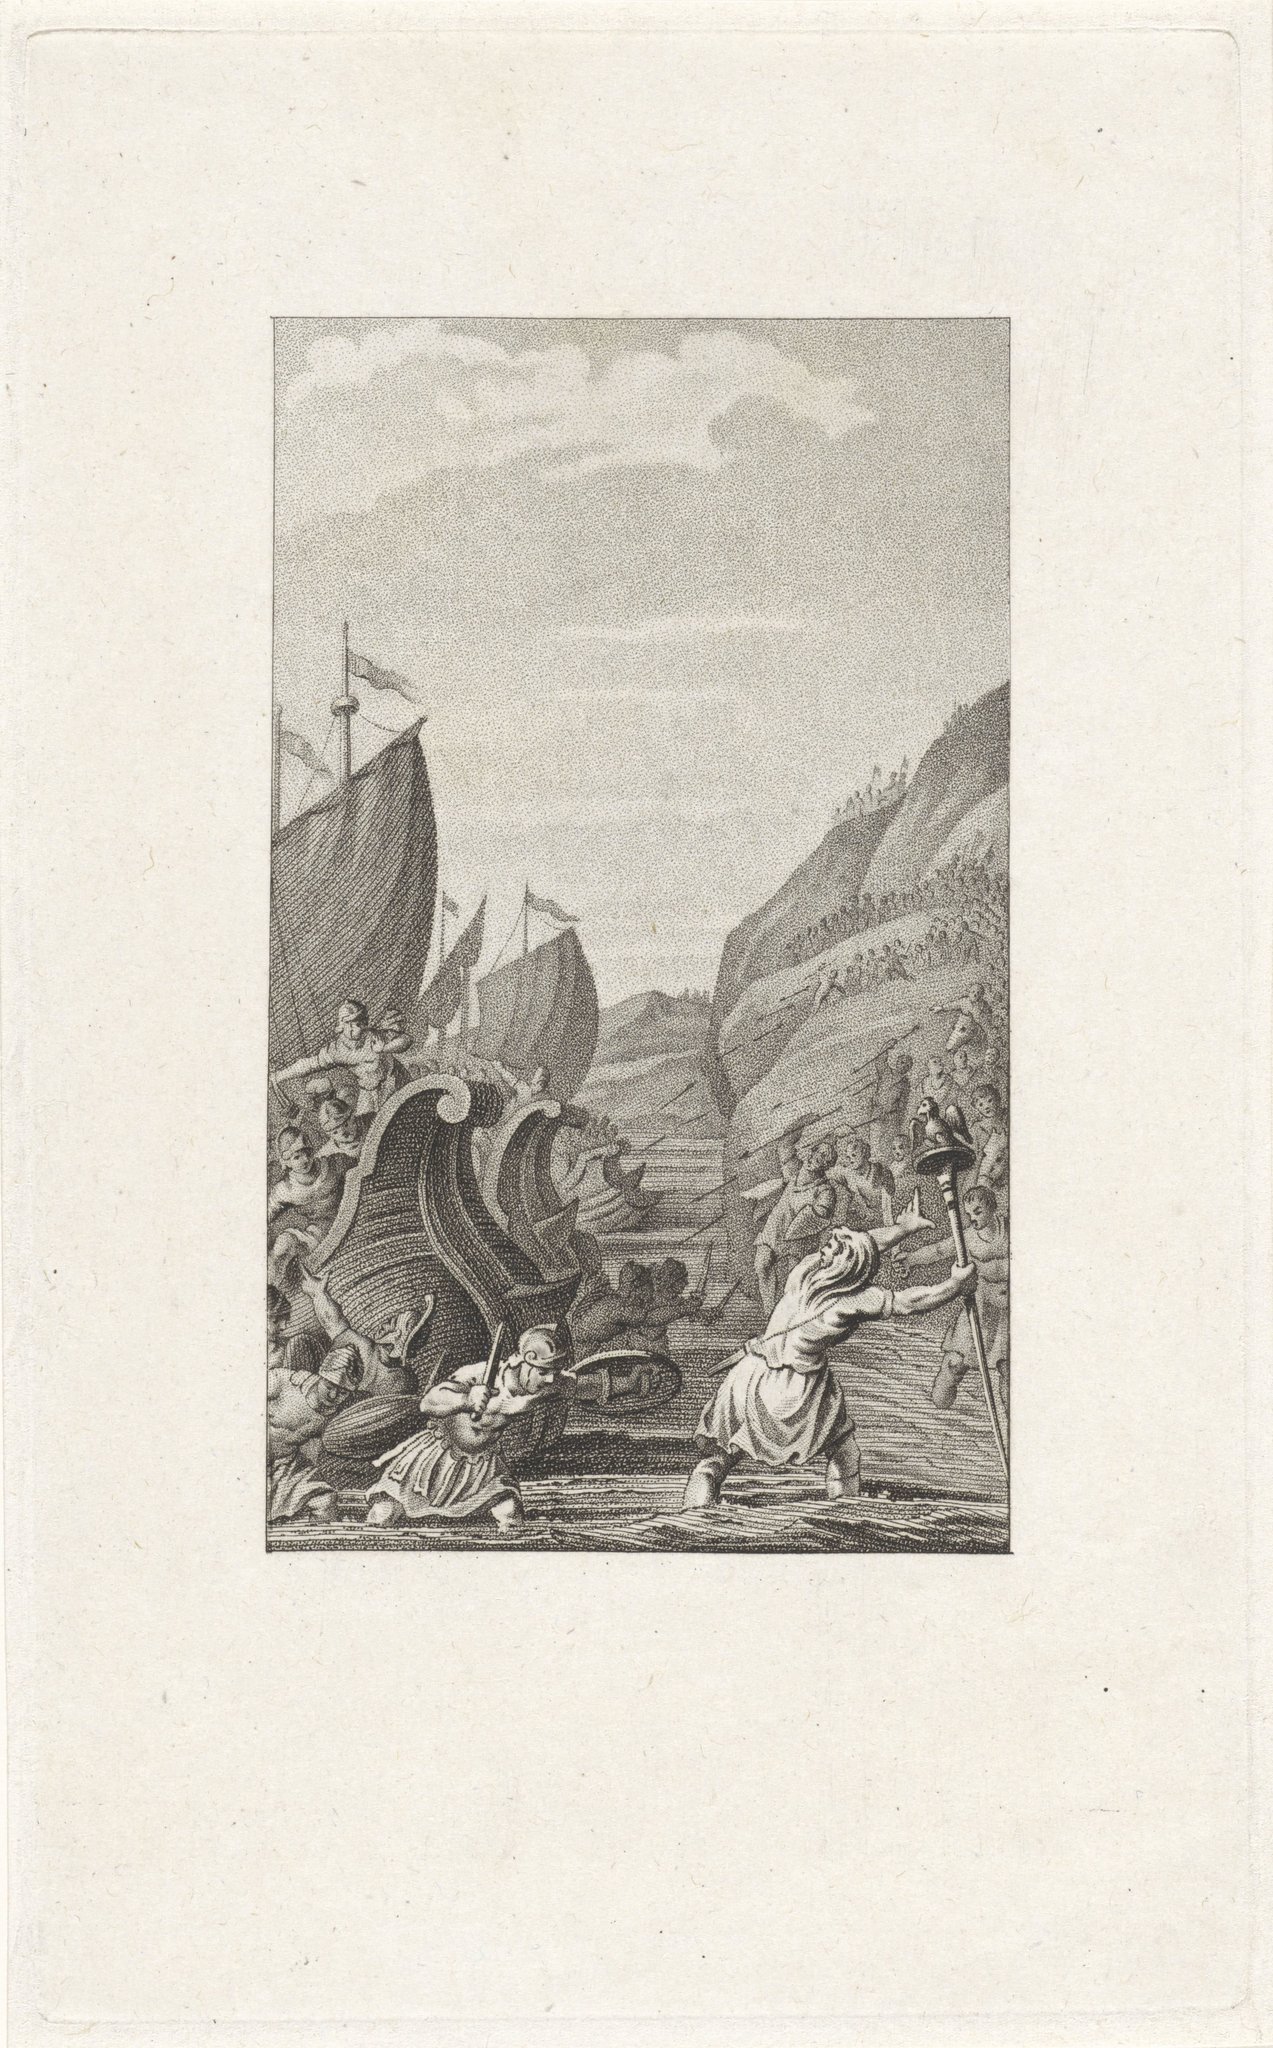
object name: print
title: Landing van de Romeinse legers van Julius Caesar in Brittannië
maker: ludwig gottlieb portman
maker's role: print maker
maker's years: 1772-1828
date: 1800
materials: paper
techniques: stippled etching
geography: amsterdam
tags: aggressive relationships of c. julius caesar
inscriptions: collector's mark: Lugt 2228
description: De Britten hebben zich naar de kust begeven en beschieten de Romeinse schepen met pijlen om hen te beletten aan land te komen. De Romeinen slingeren stenen naar de vijand.